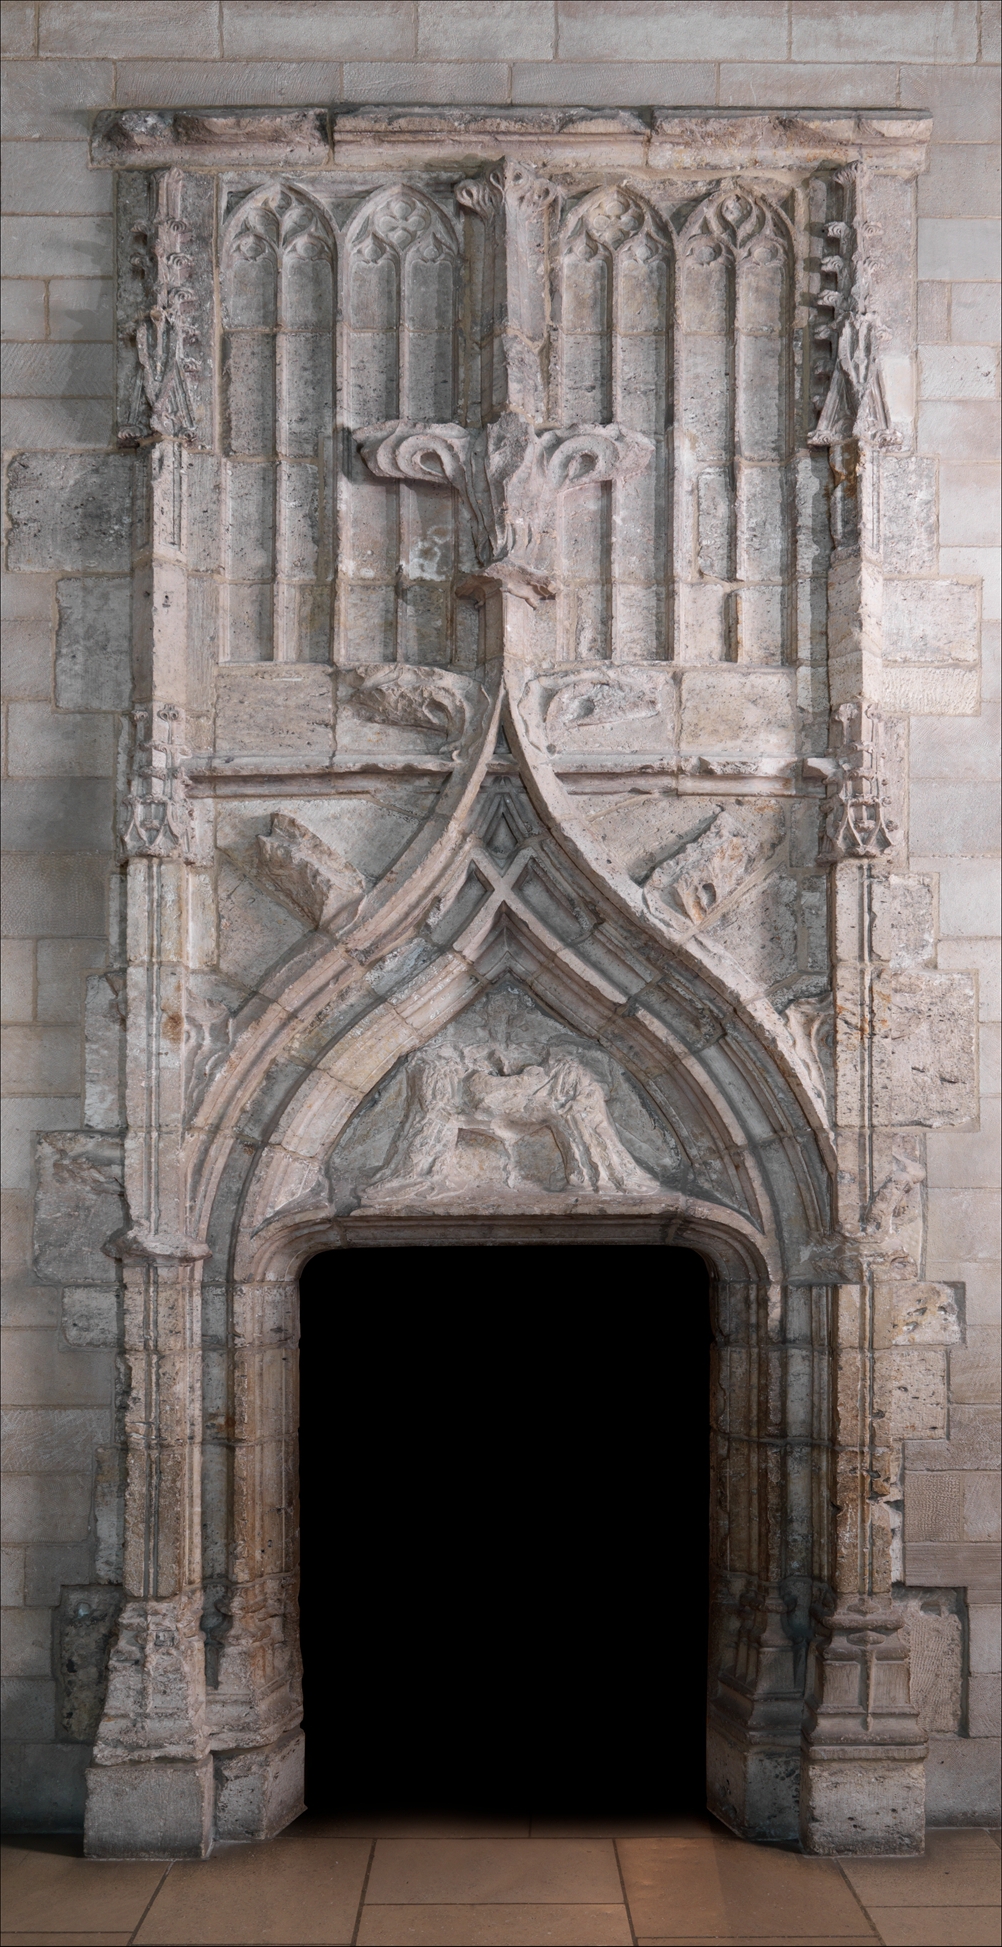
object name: doorway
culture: french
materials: limestone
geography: france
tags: doorways